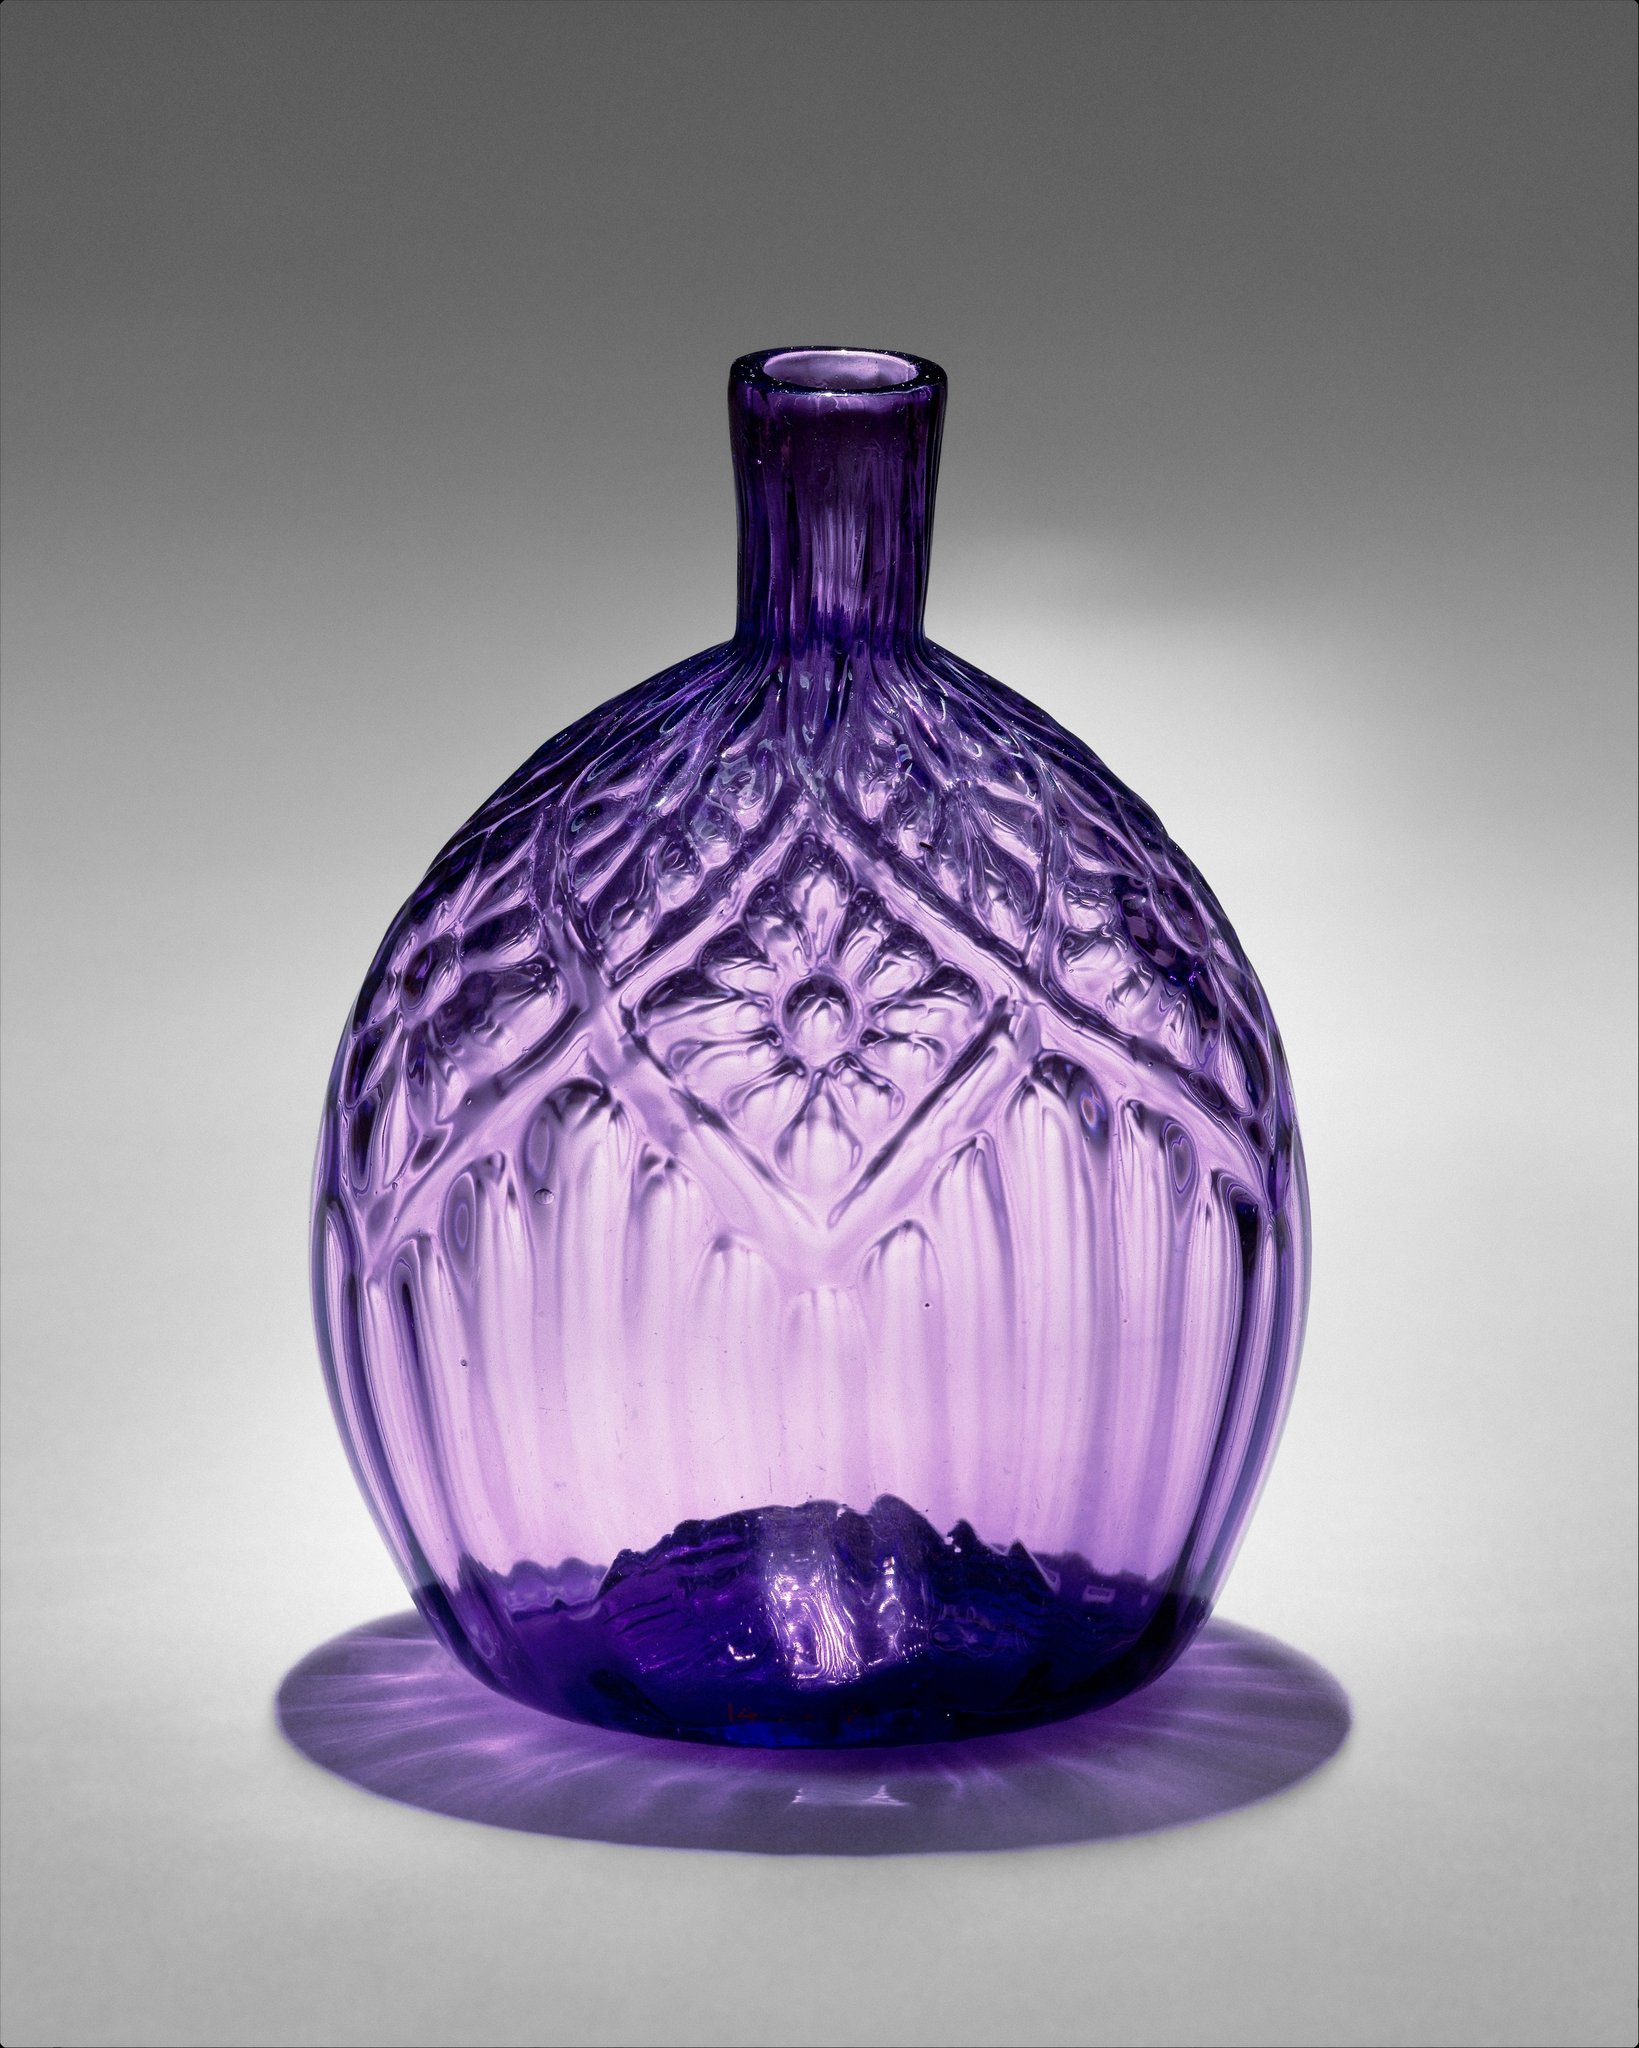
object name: pocket bottle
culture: american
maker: american flint glass manufactory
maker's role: maker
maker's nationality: american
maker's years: 1764-1774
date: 1769-1774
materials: glass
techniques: glassblowing, molding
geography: united states